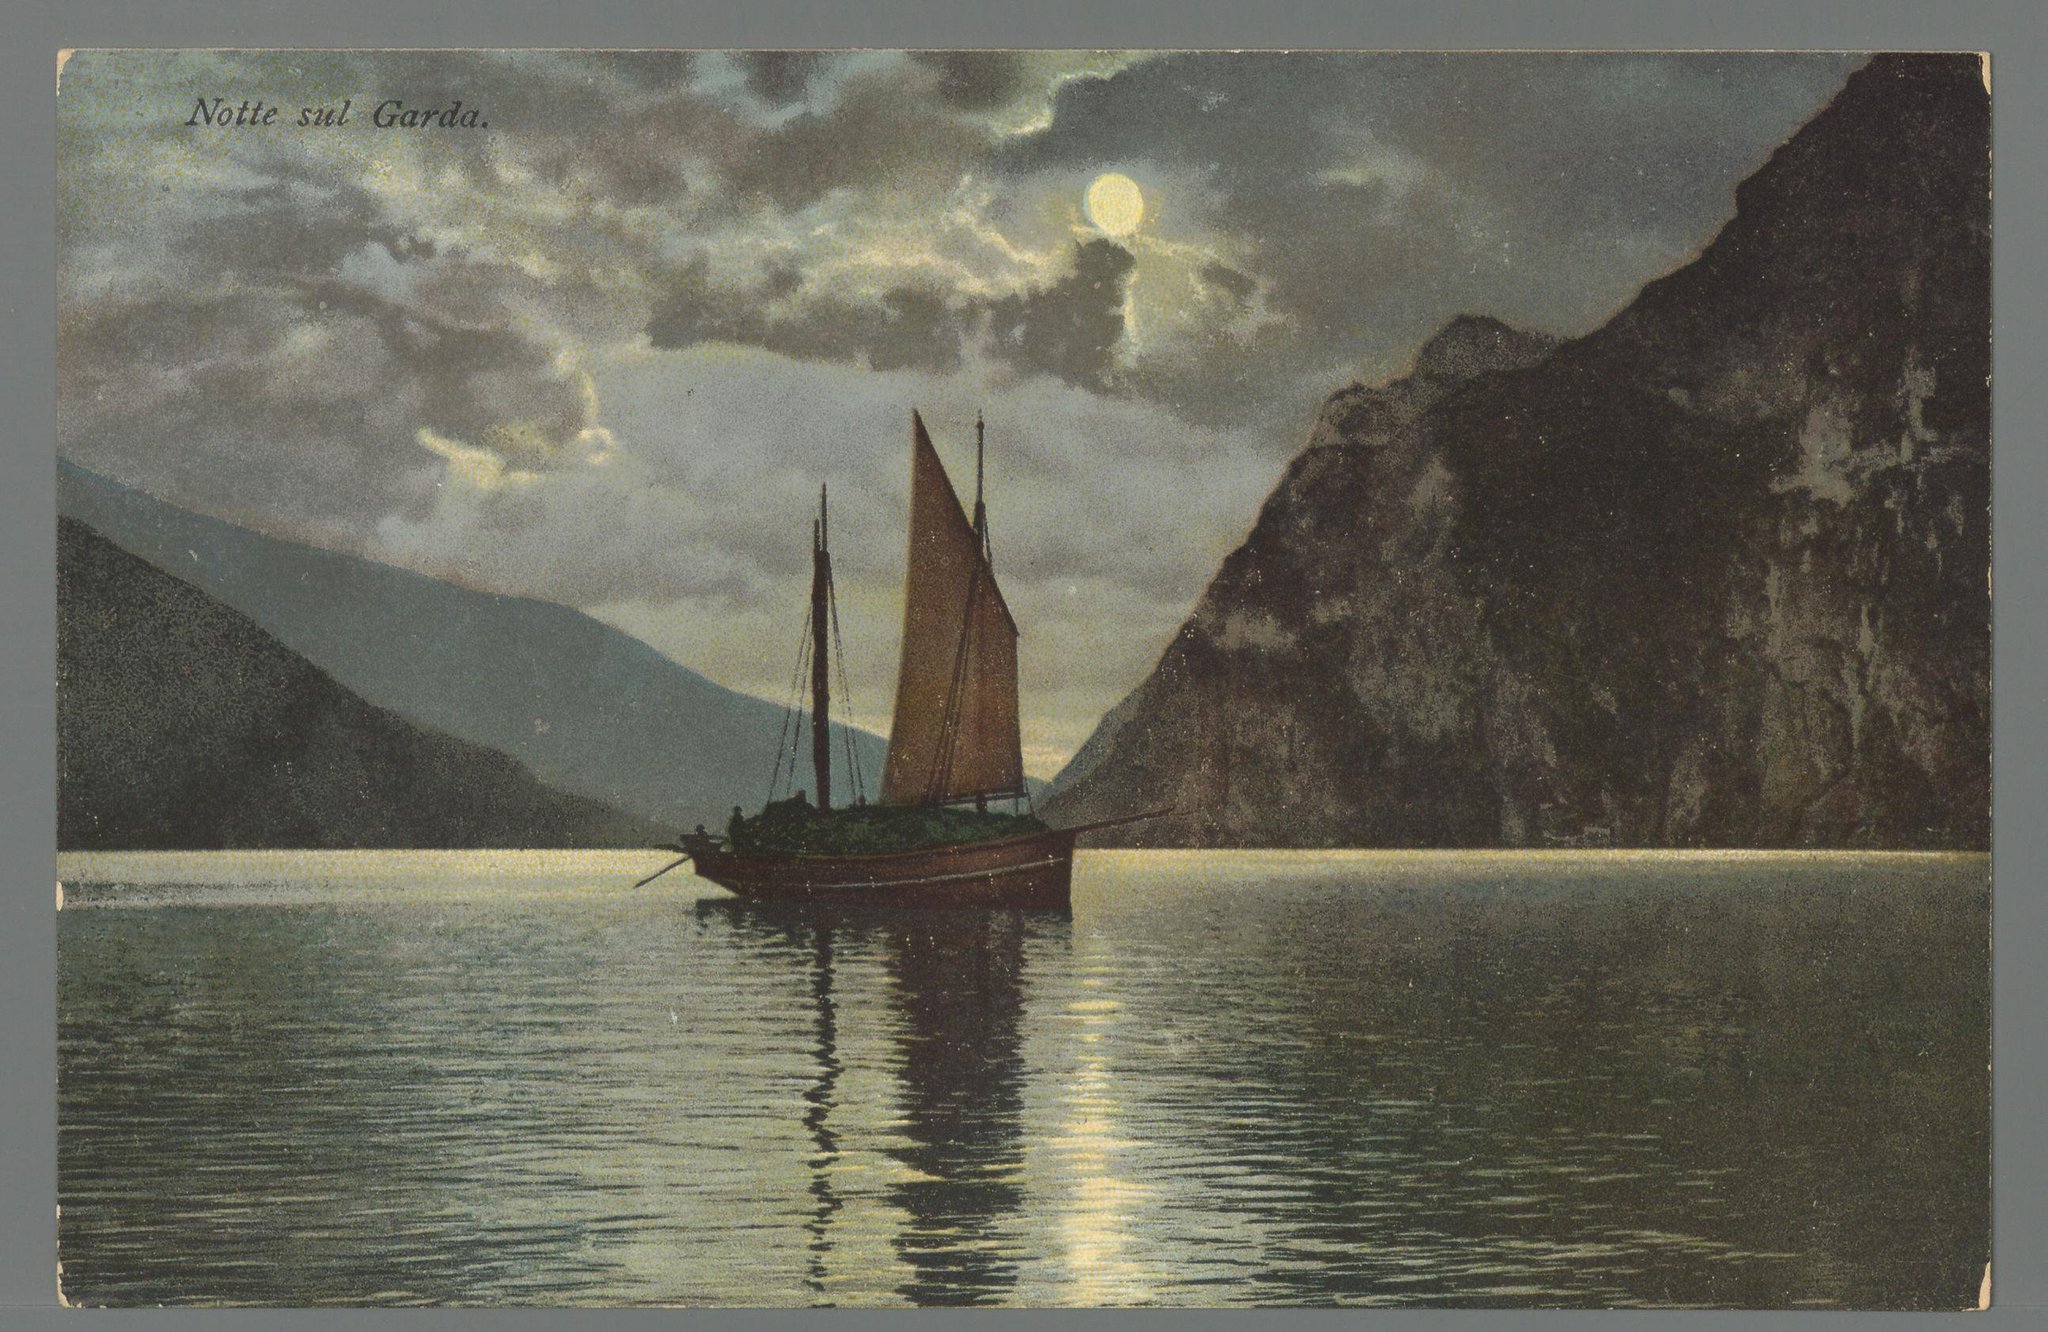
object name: ansichtkaart, prentbriefkaart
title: Notte sul Garda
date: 1906-1930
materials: cardboard, photographic process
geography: bolzano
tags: full moon, sailing-ship, sailing-boat, lake